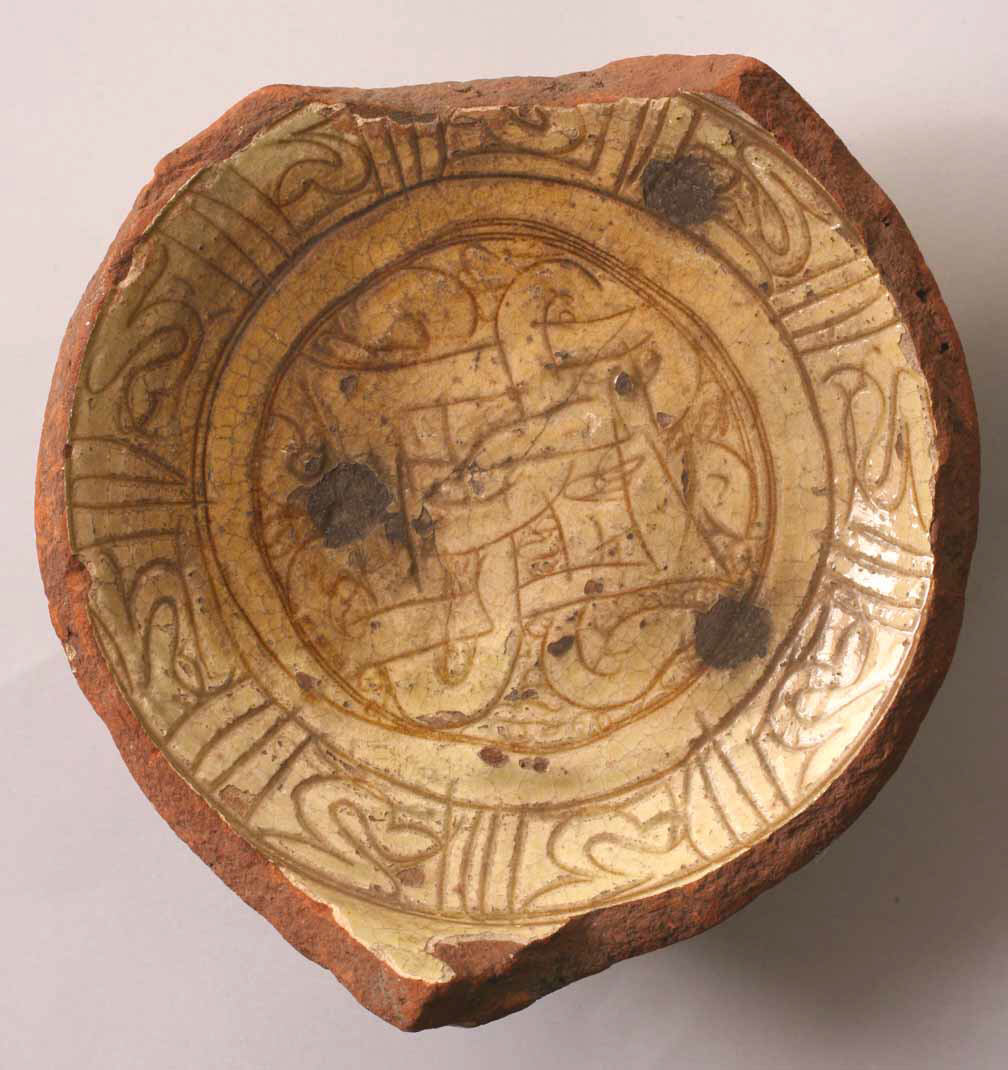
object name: fragment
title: Fragment of a Bowl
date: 1301-1500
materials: earthenware, glaze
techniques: coloring, incising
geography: egypt